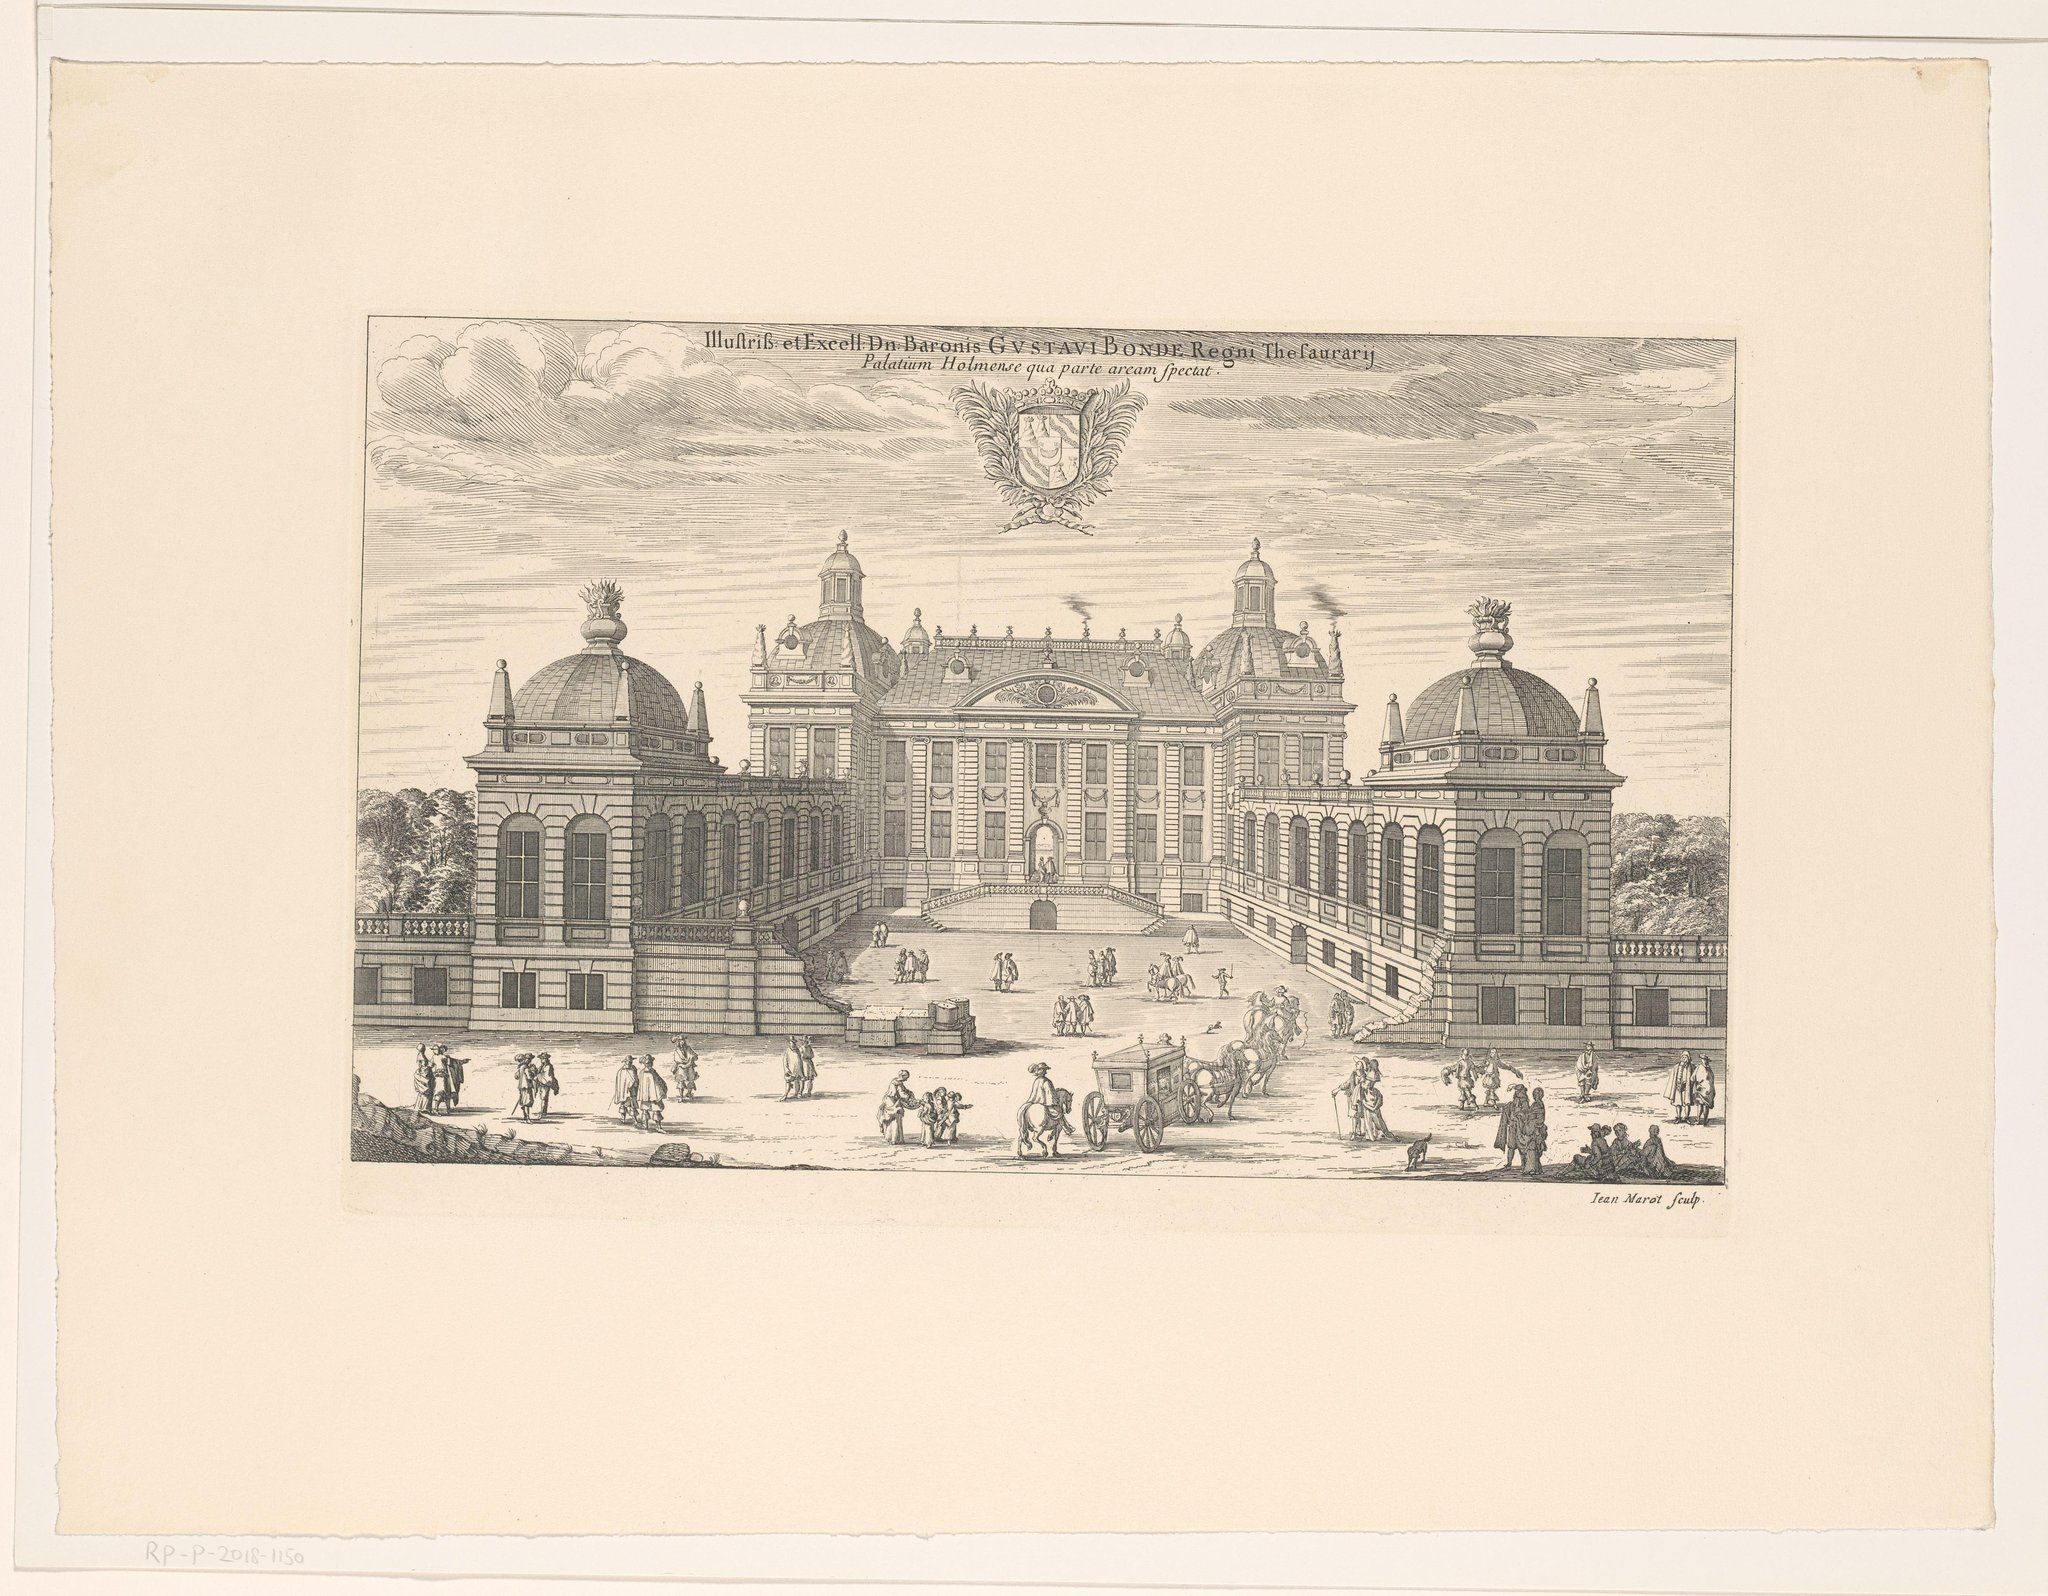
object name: print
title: Gezicht op het Bondepaleis, te Stockholm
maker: jean marot (i)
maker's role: print maker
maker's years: 1619-1679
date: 1699-1715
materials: paper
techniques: engraving, etching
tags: palace, armorial bearing, heraldry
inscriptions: collector's mark: ‘Nationalmuseum Nytryck’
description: Gezicht op het Bondepaleis, te Stockholm. Boven, in het midden, het wapen van Gustaf Bonde, die opdracht gaf tot de bouw van het paleis.